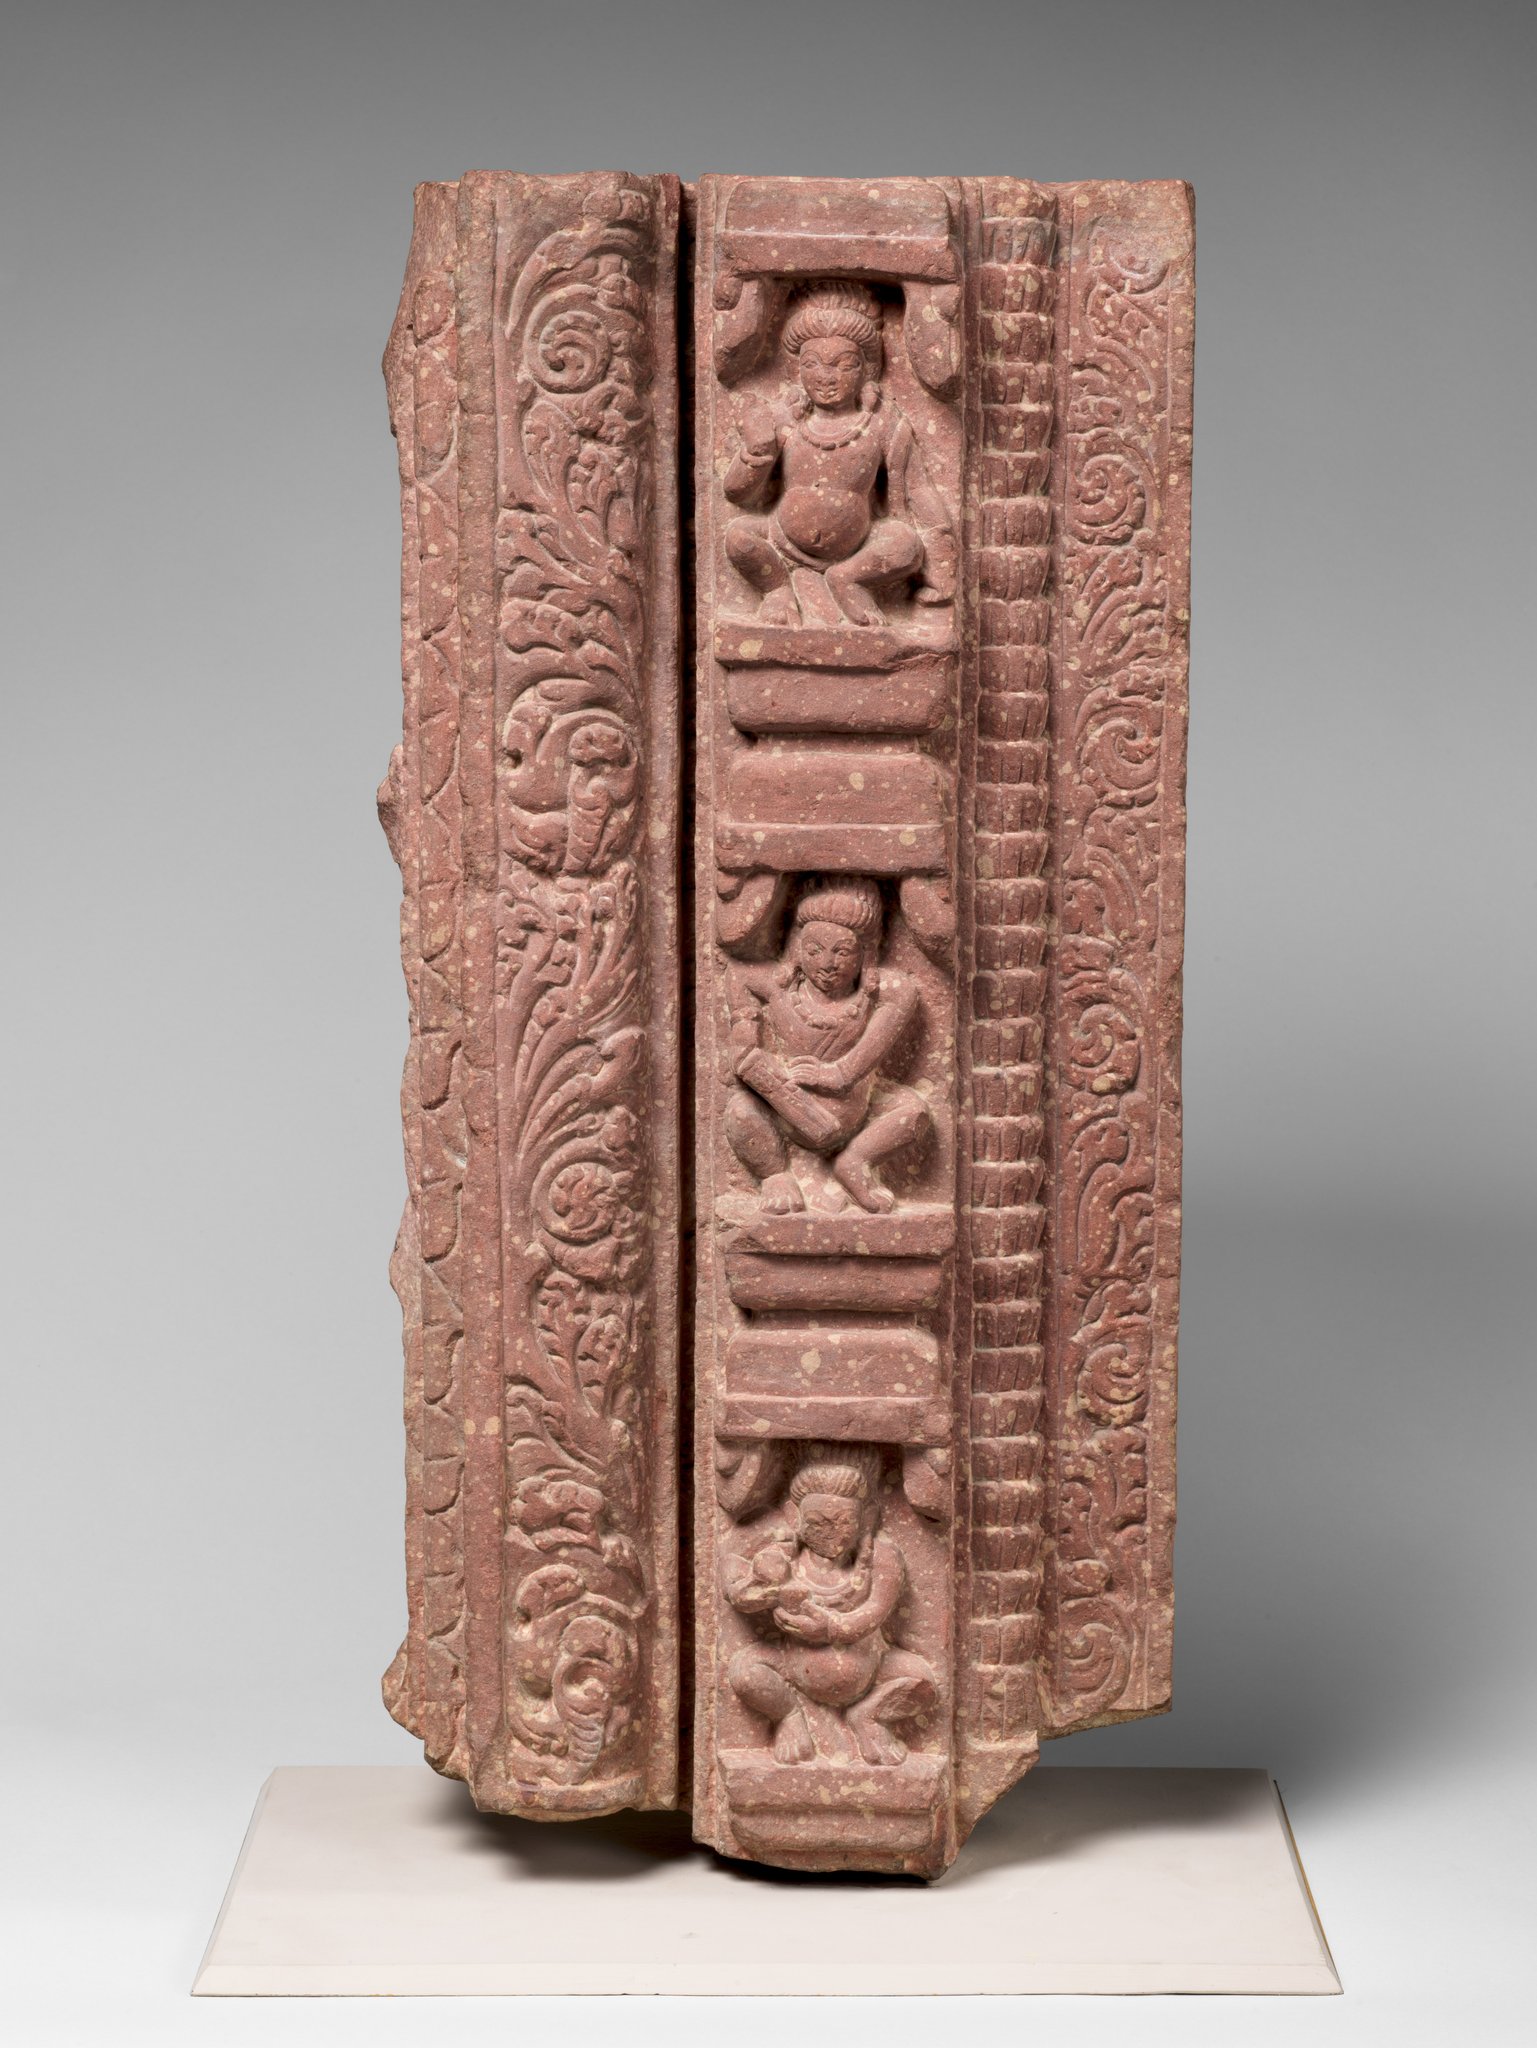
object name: doorframe fragment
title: Doorframe with Three Ganas (Nature Deities) Dancing and Playing Instruments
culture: indian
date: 501-700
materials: stone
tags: post-gupta,dancing